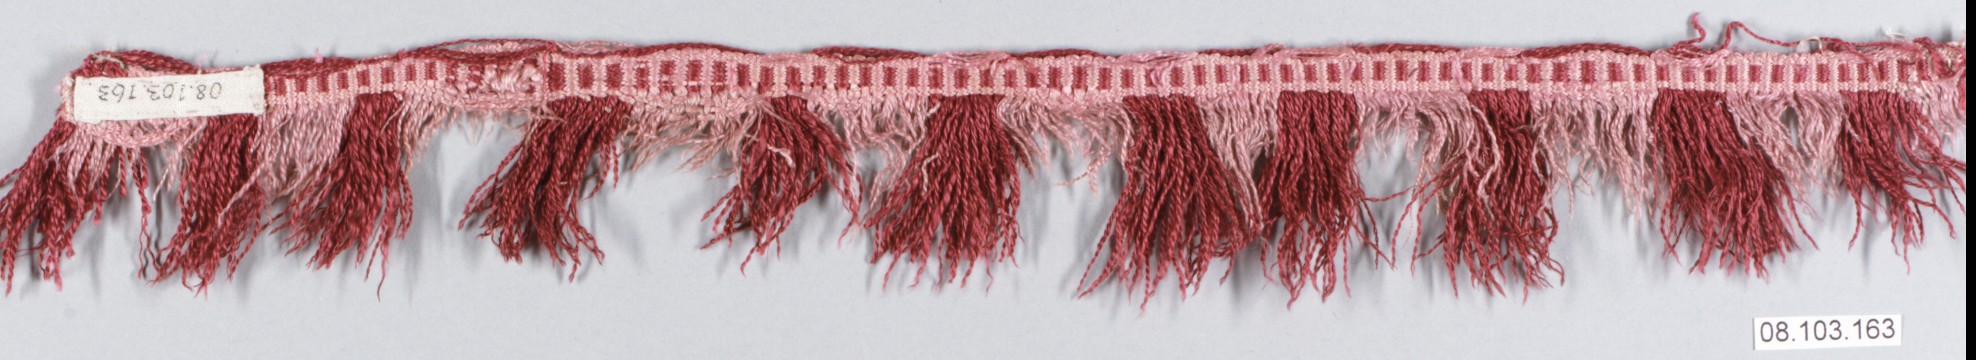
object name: fringe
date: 1801-1900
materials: silk